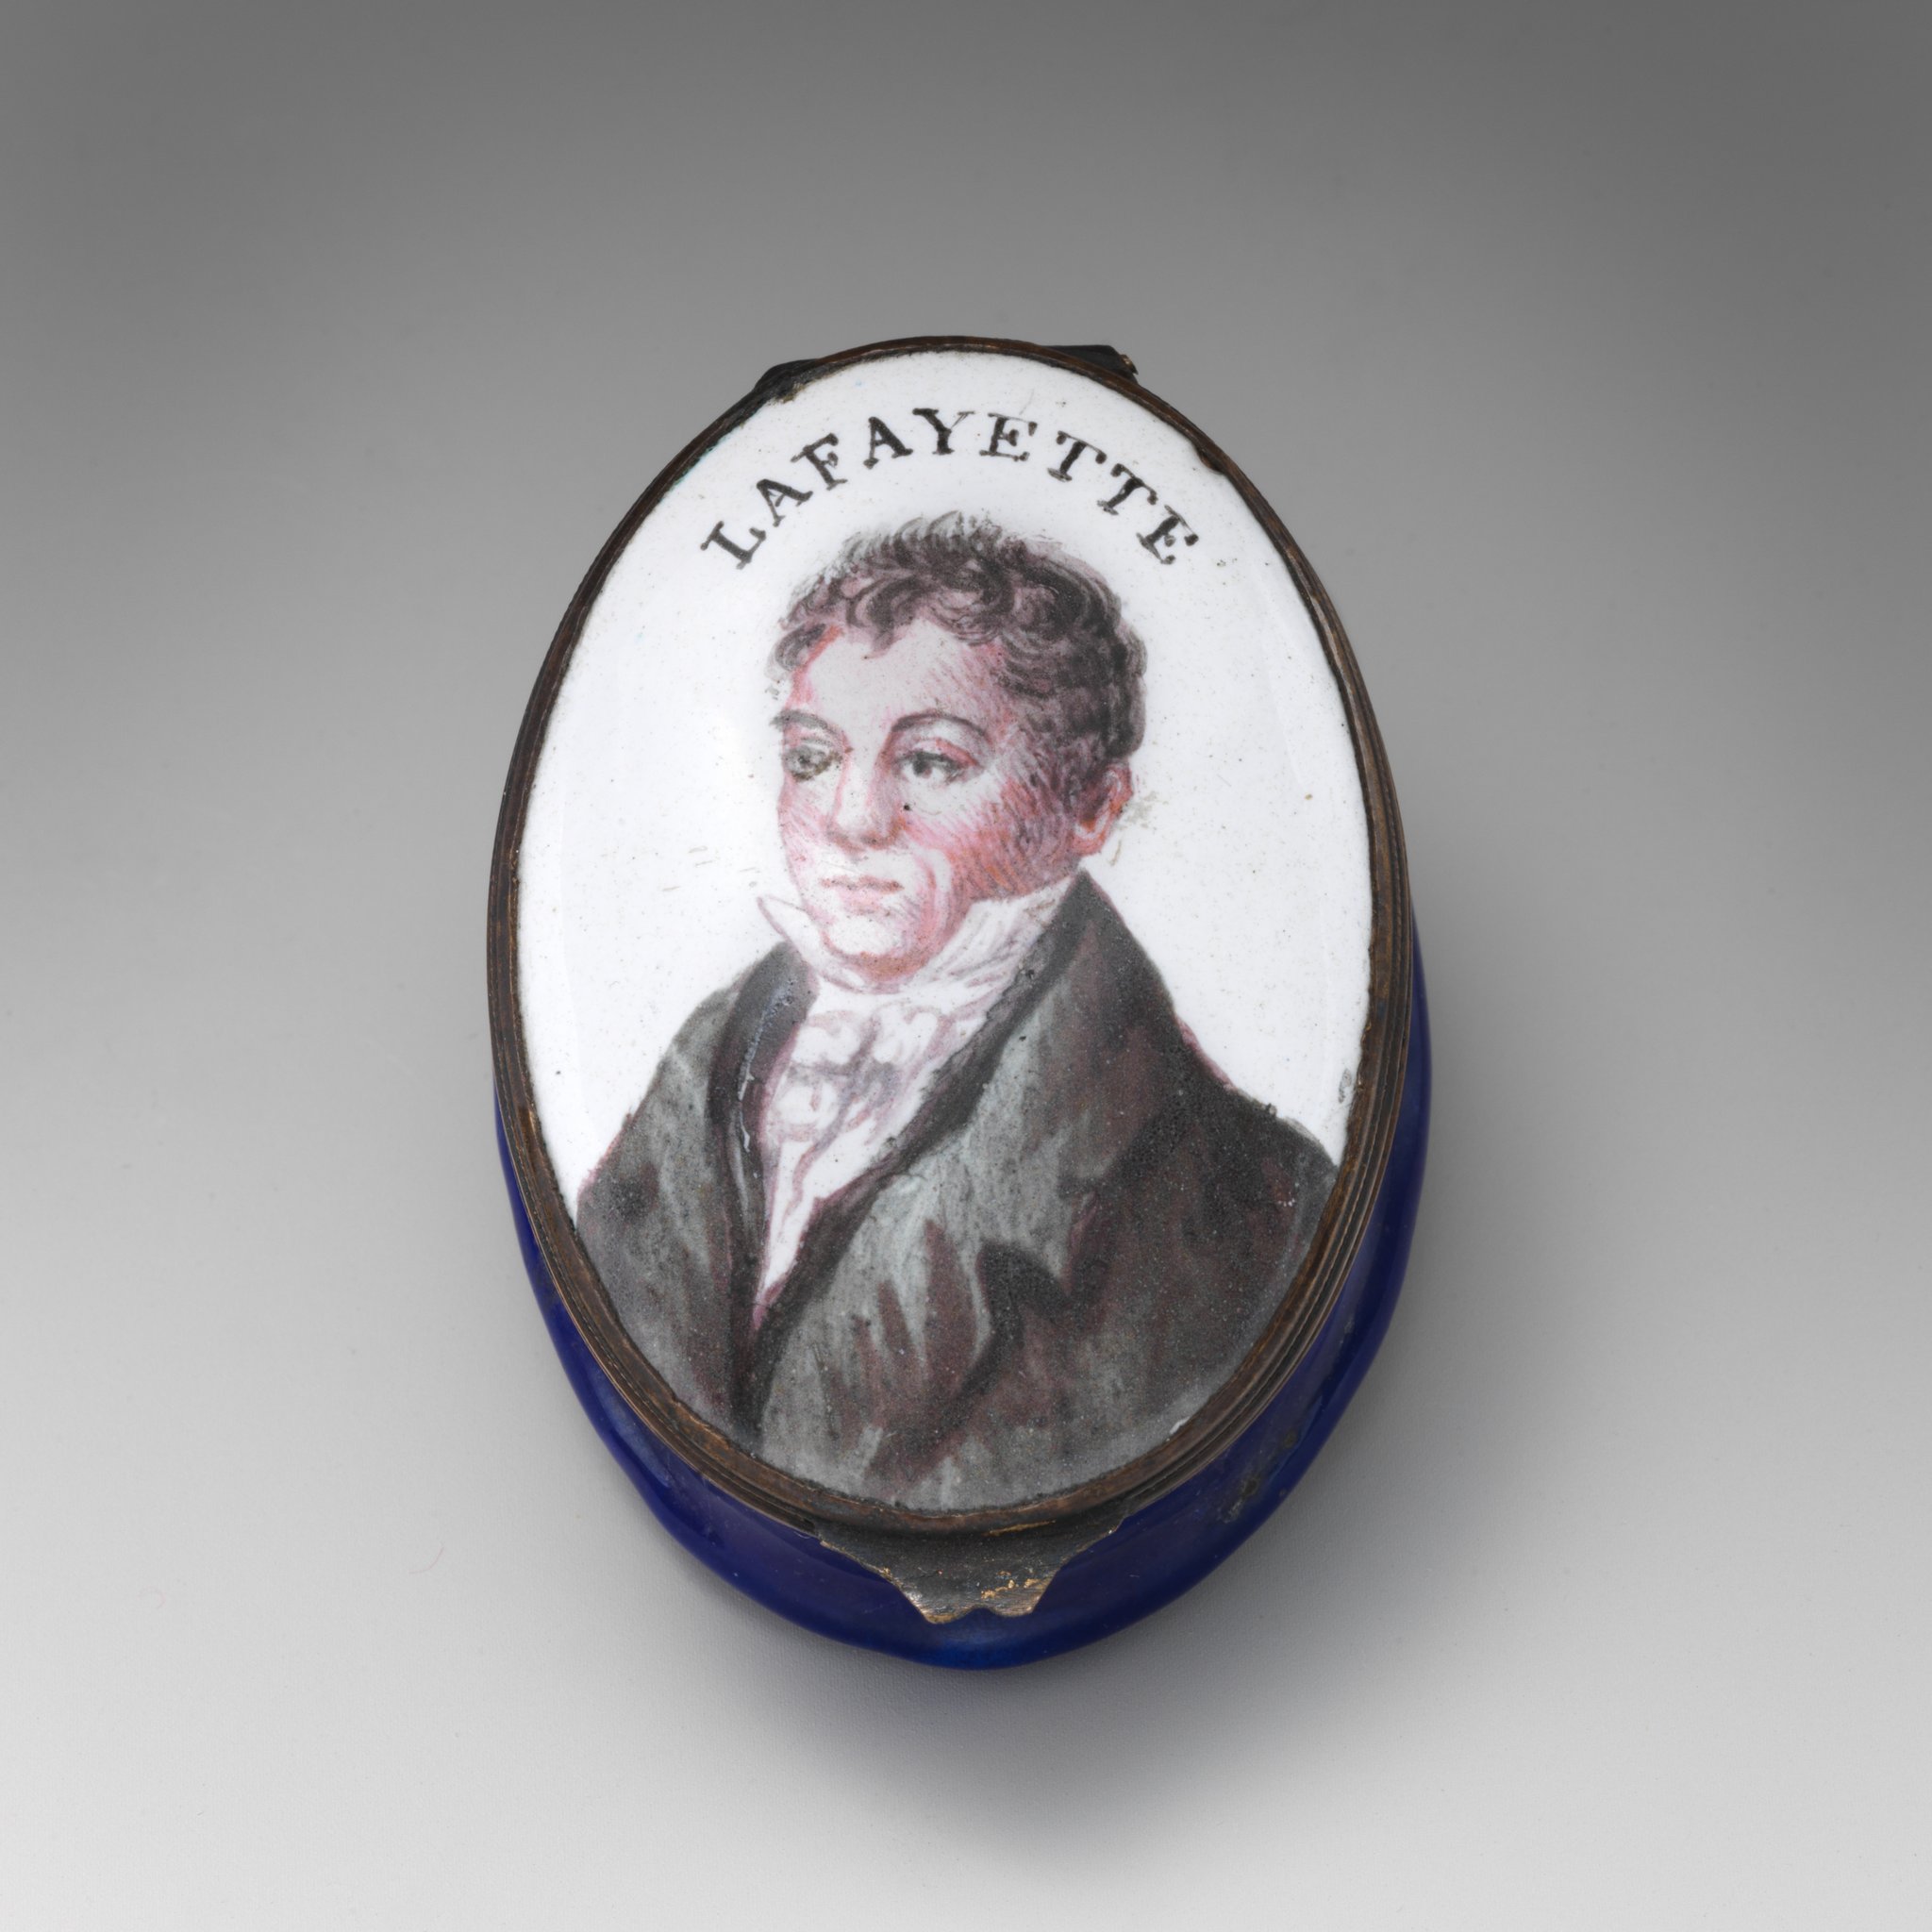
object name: patch box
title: Patch box with portrait of the Marquis de Lafayette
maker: samson and company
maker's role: manufactory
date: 1875-1900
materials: copper, enamel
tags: men,portraits